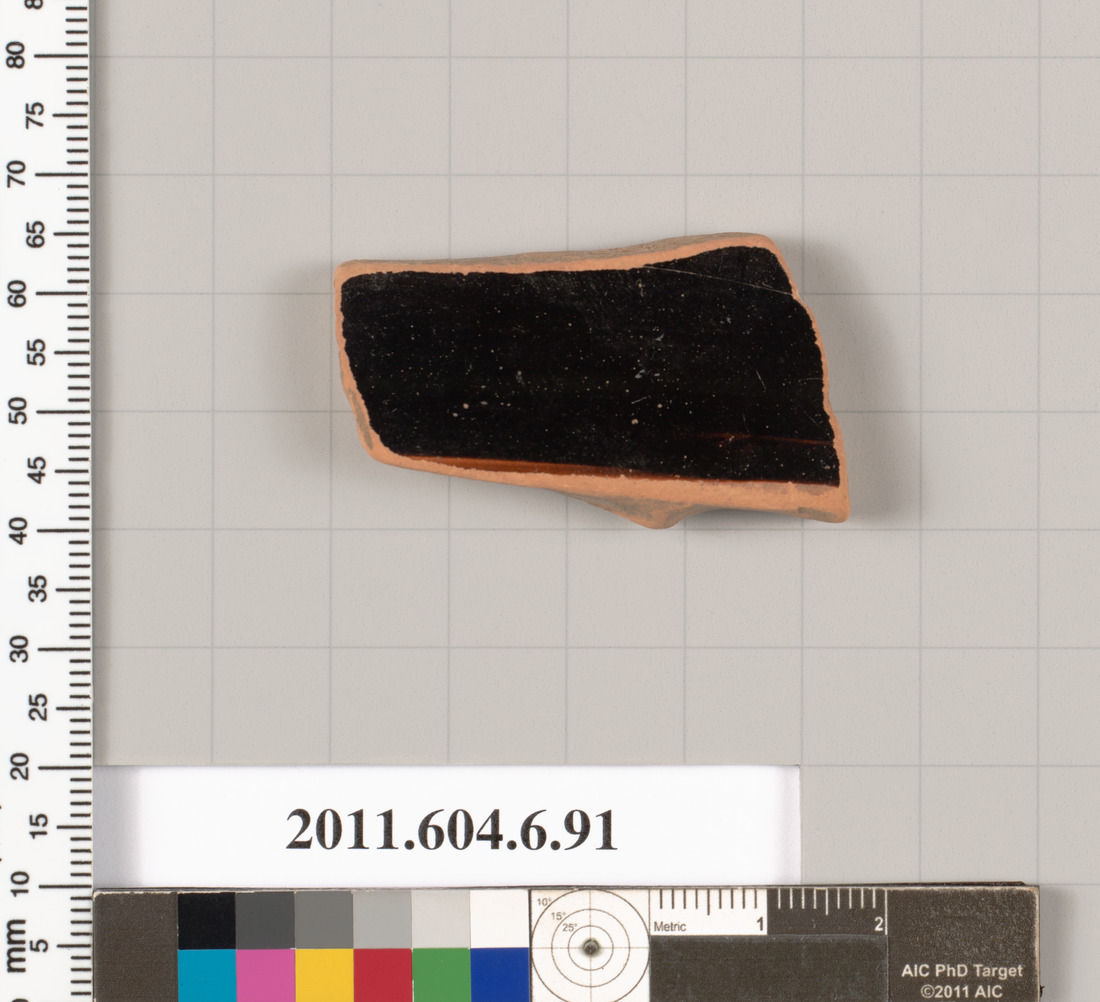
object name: amphora fragment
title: Terracotta fragment of an amphora (jar)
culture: greek, attic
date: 600-401 BCE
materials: terracotta